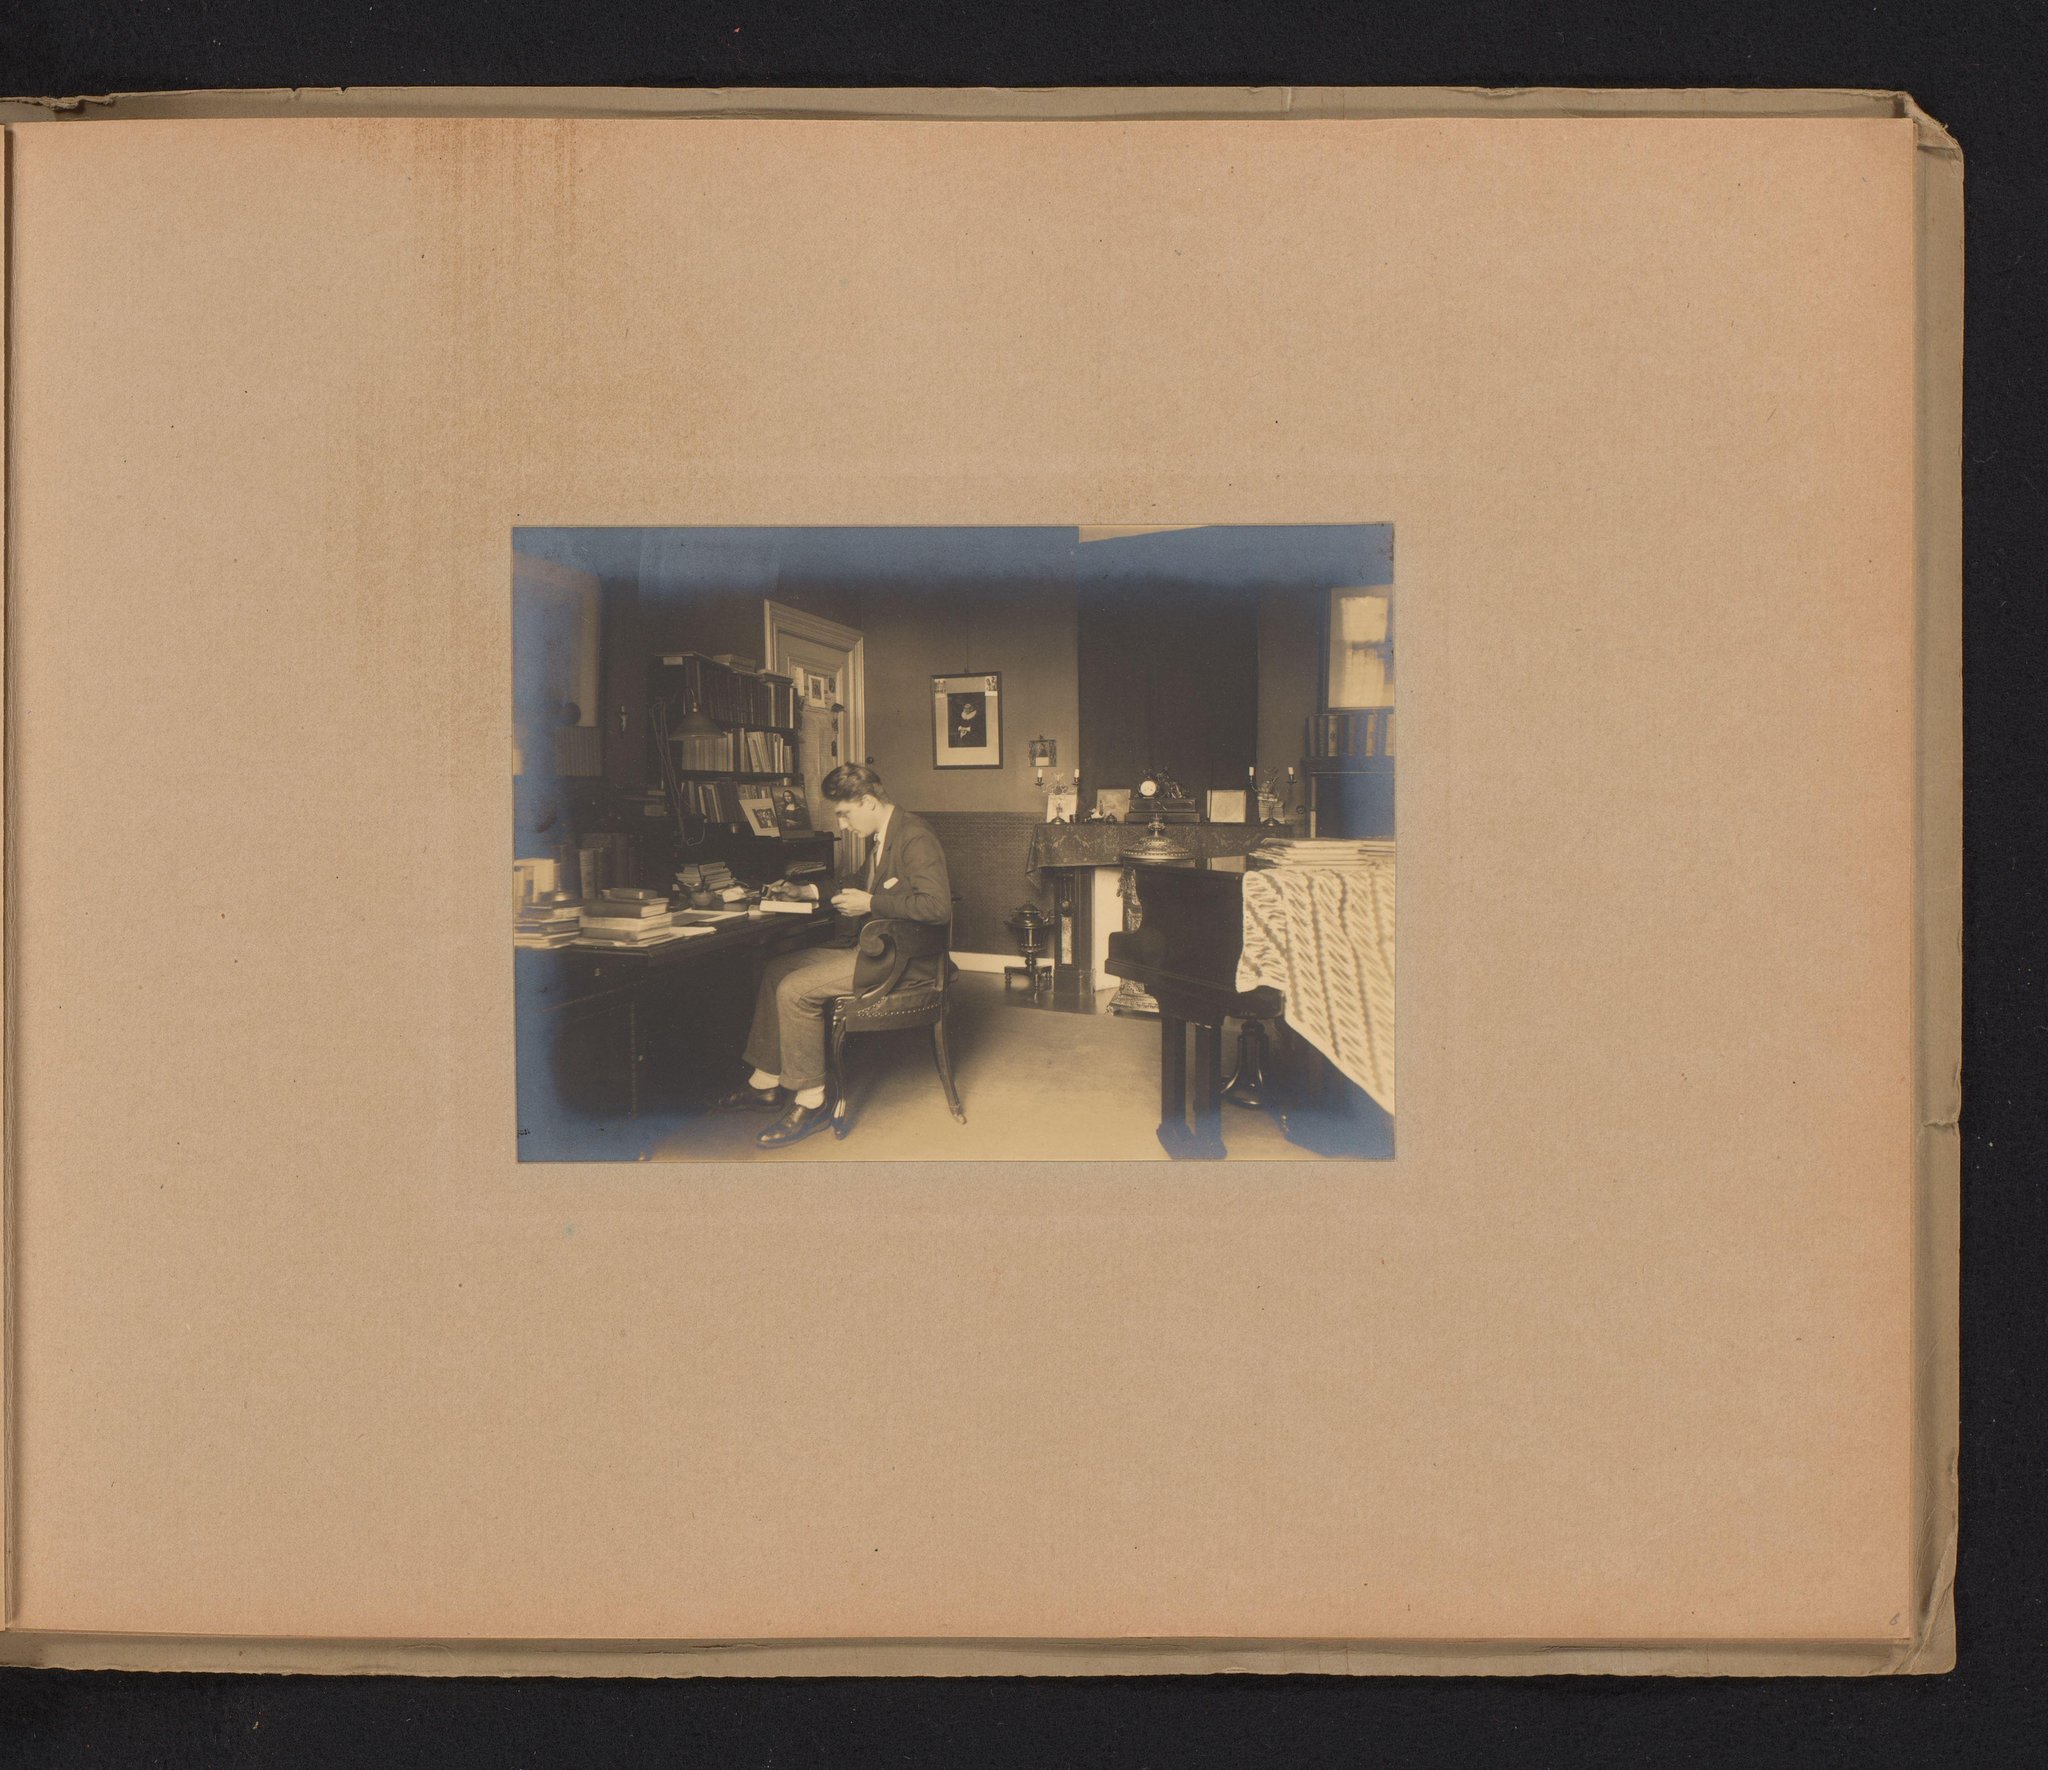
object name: photograph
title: Portret van Goverdus Henricus Jonker, studerend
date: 1890-1915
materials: paper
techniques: gelatin silver print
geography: bussum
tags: writing-table, writing-desk, historical persons